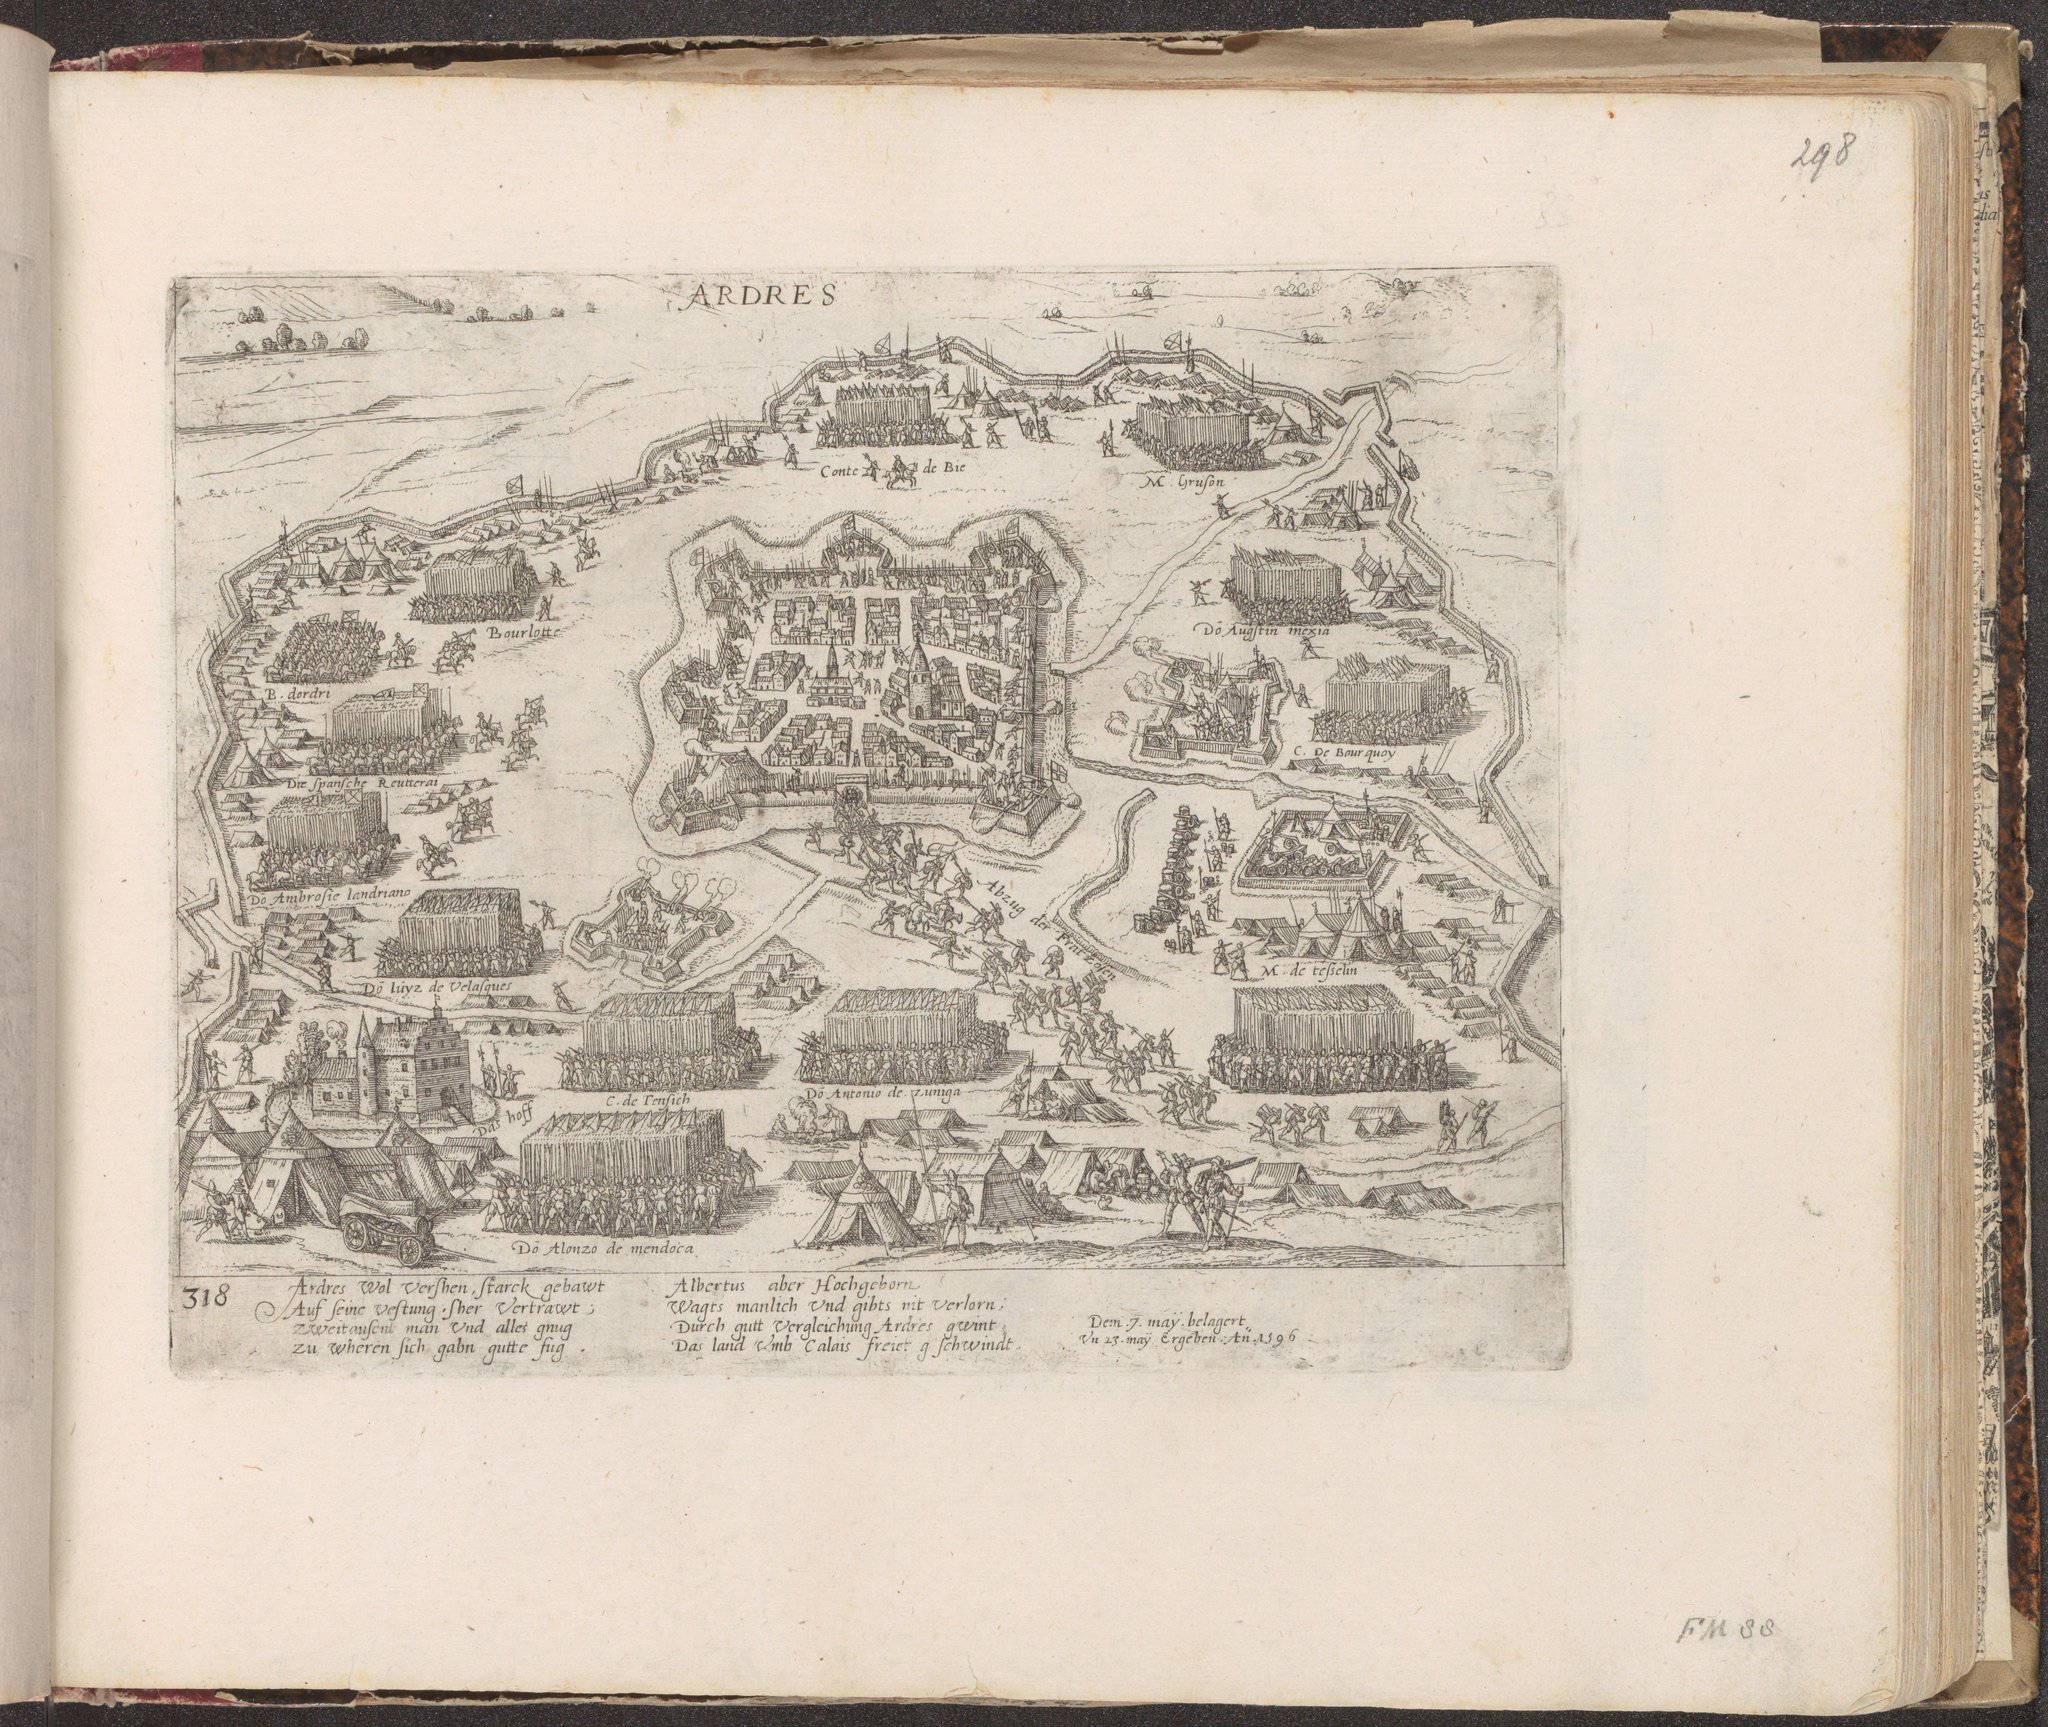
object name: print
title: Verovering van Ardres, 1596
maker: frans hogenberg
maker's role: print maker, publisher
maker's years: 1538-1590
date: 1596-1598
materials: paper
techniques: etching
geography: cologne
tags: brussels, albrecht aartshertog van oostenrijk, capture of city (after the siege)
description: Verovering van Ardres door Albrecht van Oostenrijk, 23 mei 1596. De Franse troepen verlaten de omsingelde stad. Met onderschrift van 8 regels in het Duits. Linksonder genummerd: 318. De prent maakt deel uit van een album.